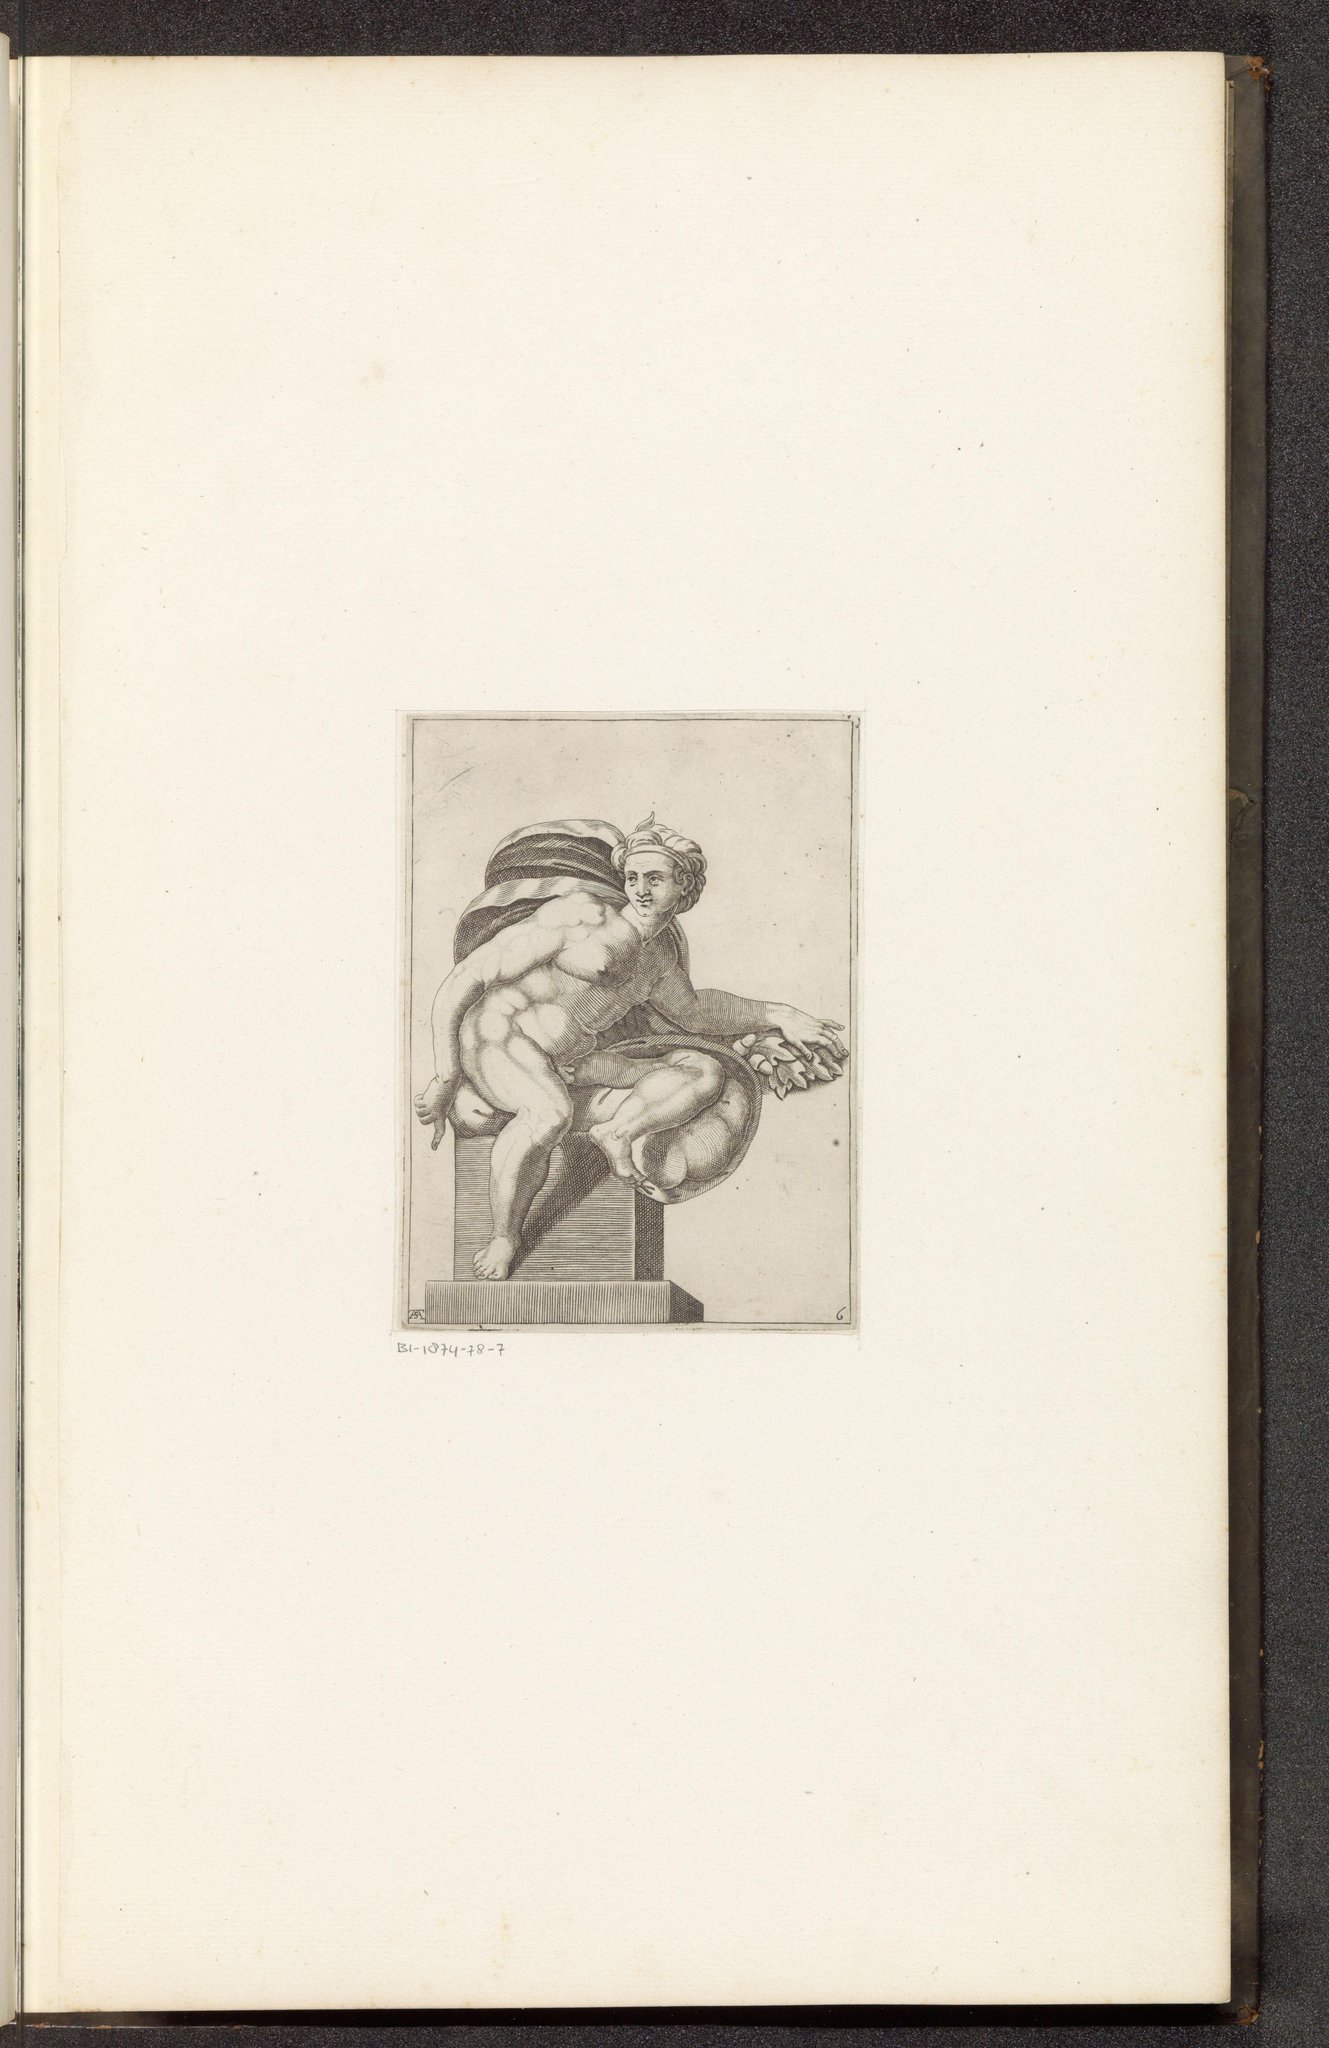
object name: print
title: Schilderingen in de Sixtijnse kapel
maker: adamo scultori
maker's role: painter, print maker, sculptor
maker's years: 1530-1585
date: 1585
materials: paper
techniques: engraving, intaglio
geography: vatican city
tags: the (nude) human figure; 'corpo humano' (ripa), fruits: acorn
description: Zittende naakte man, naar rechts gedraaid, met een guirlande van eikels. Eén van de 'ignudi' (naakte mannen) van Michelangelo's plafondschildering. Genummerd rechtsonder: 6. De prent maakt deel uit van een album.